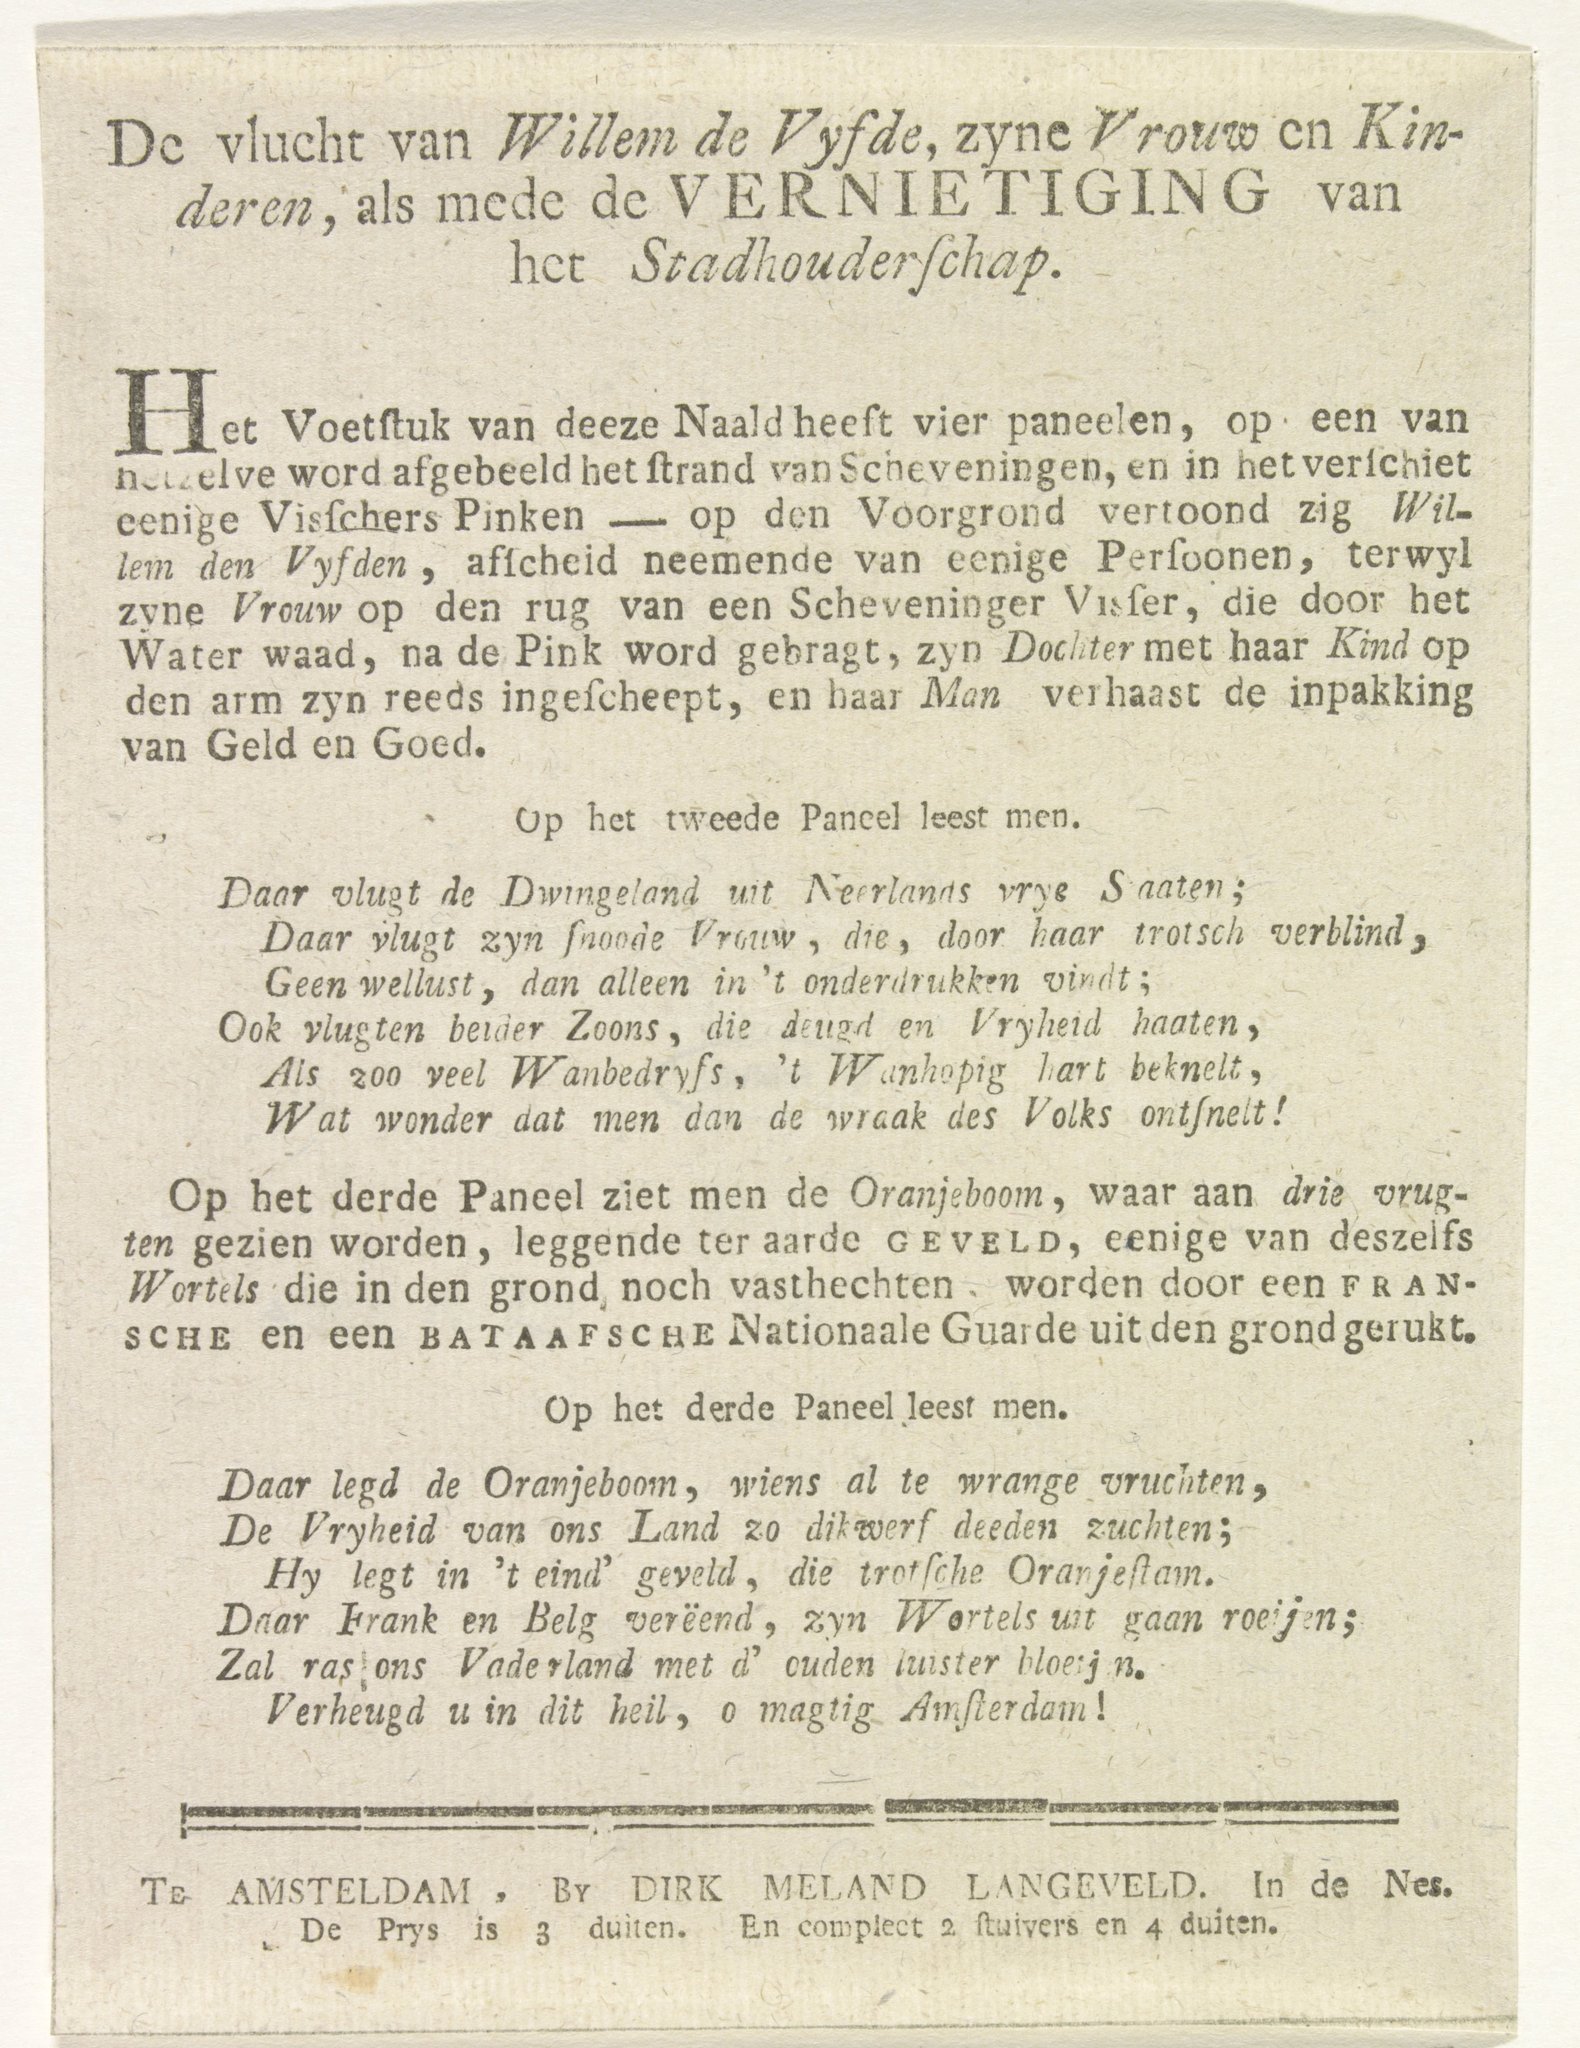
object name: text sheet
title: Vlucht van Willem V en Vernietiging van het Stadhouderschap, decoratie in de Plantage, 1795 (uitleg)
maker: dirk meland langeveld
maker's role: publisher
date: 1795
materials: paper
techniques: letterpress printing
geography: amsterdam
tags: amsterdam, alliance with france (1795)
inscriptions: collector's mark: Lugt 2228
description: Tekstblad met uitleg van de voorstellingen van De vlucht van prins Willem V en De Vernietiging van het Stadhouderschap, allegorische decoratie opgericht in de Plantage te Amsterdam. Waarschijnlijk behorend bij een afzonderlijke uitgave van de losse platen van de versieringen opgericht in de stad bij de viering van de installatie van de representanten en de alliantie gesloten tussen de Franse en de Bataafse Republiek, 19 juni 1795.